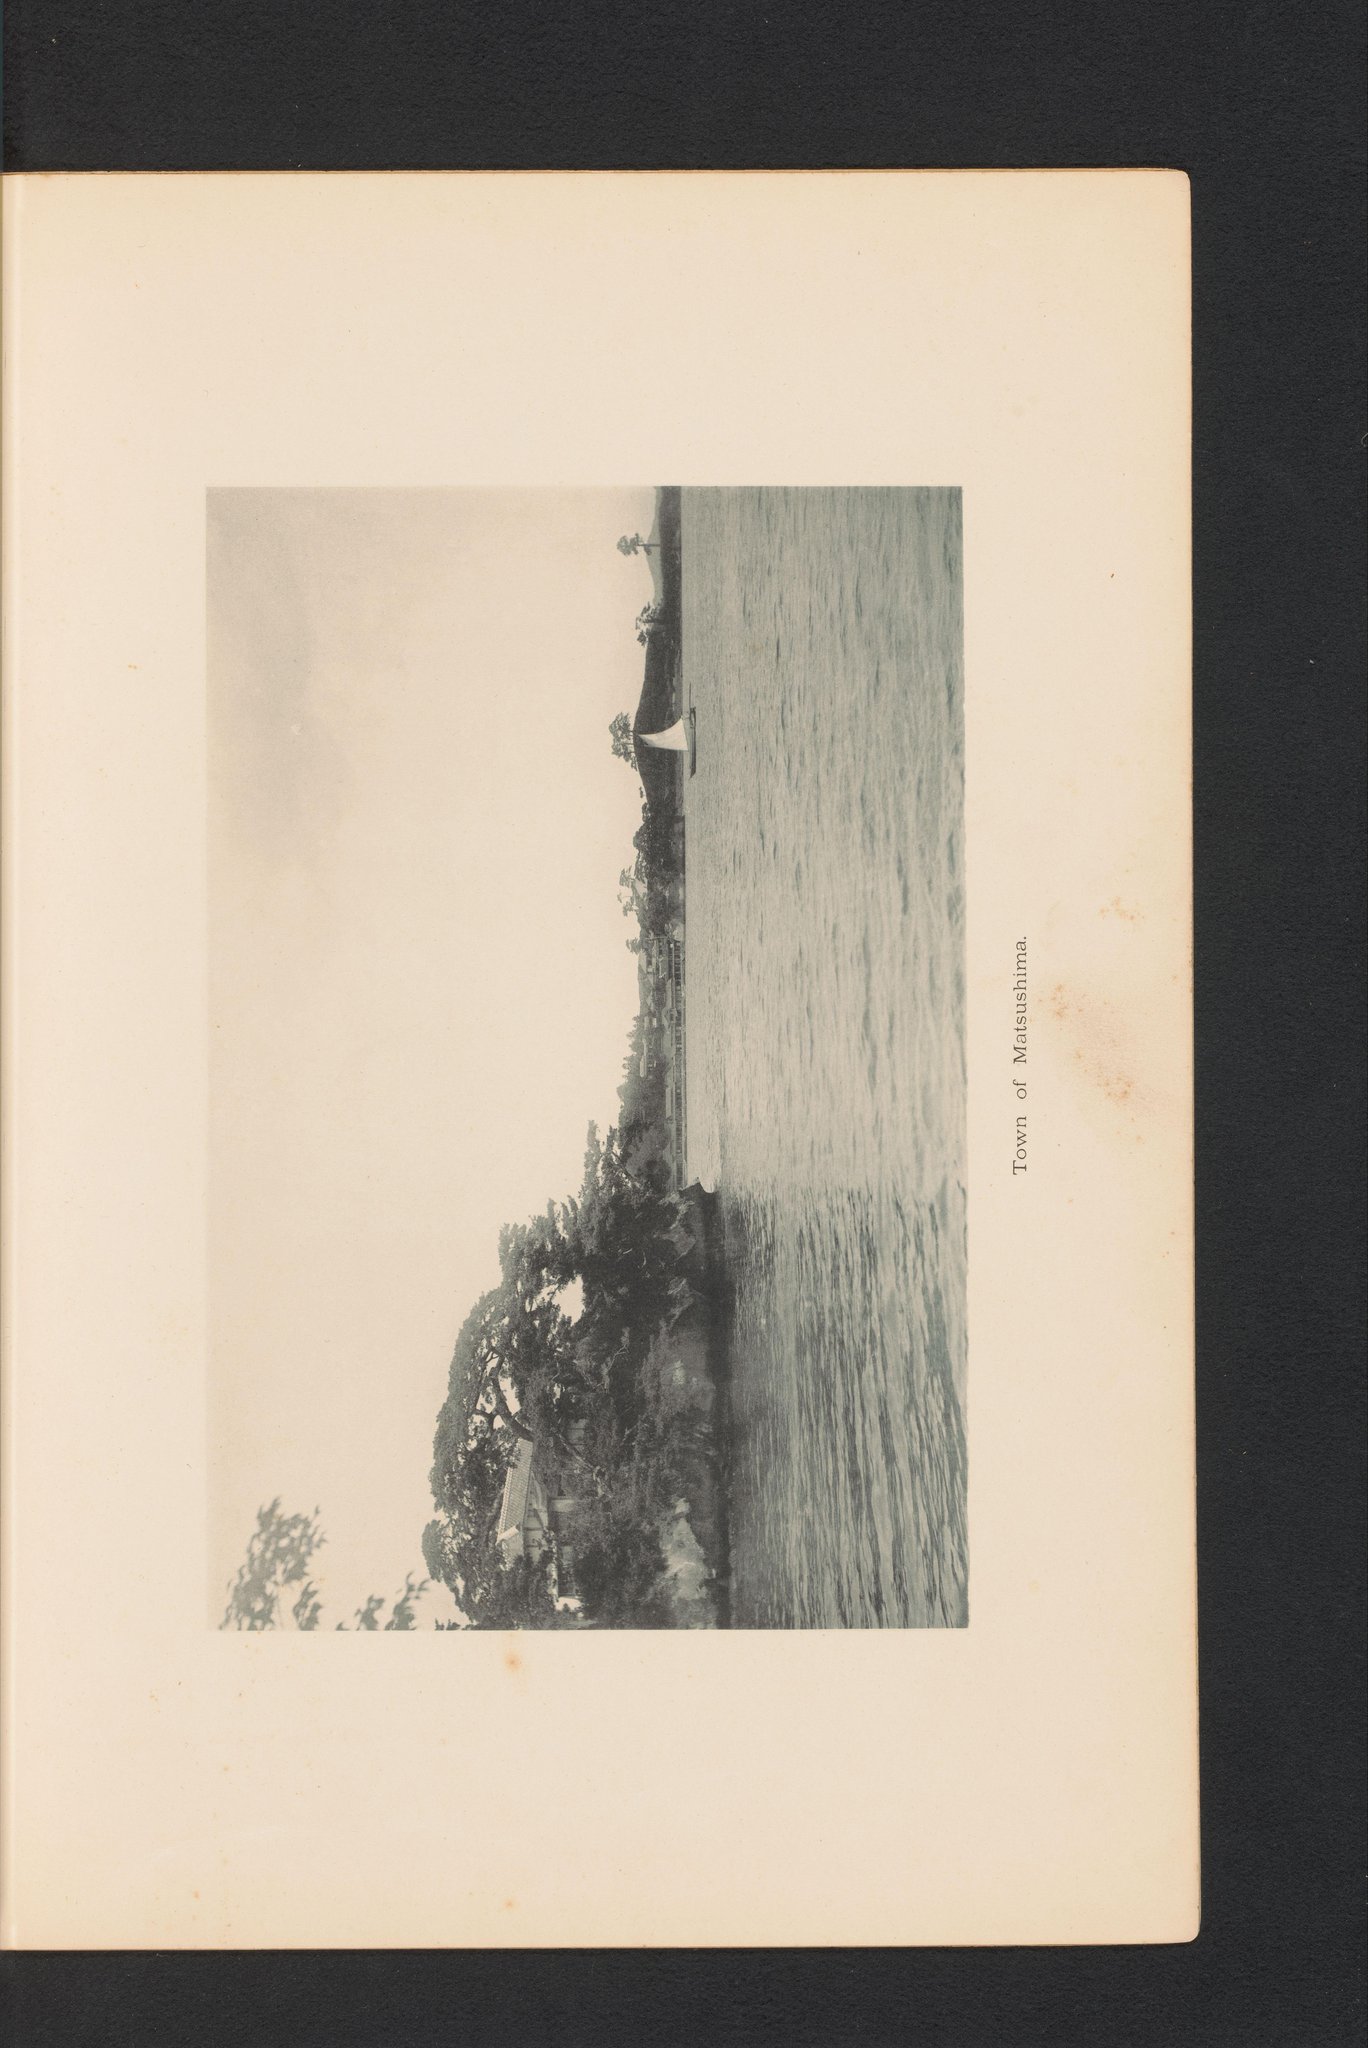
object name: photomechanical print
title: Gezicht op Matsushima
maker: kazumasa ogawa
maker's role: auteur, fotograaf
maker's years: 1860-1929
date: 1890-1895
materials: paper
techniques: photograph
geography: matsushima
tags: sailing-ship, sailing-boat, city-view in general; 'veduta', landscapes with waters, waterscapes, seascapes (in the temperate zone) (+ landscape with figures, staffage)